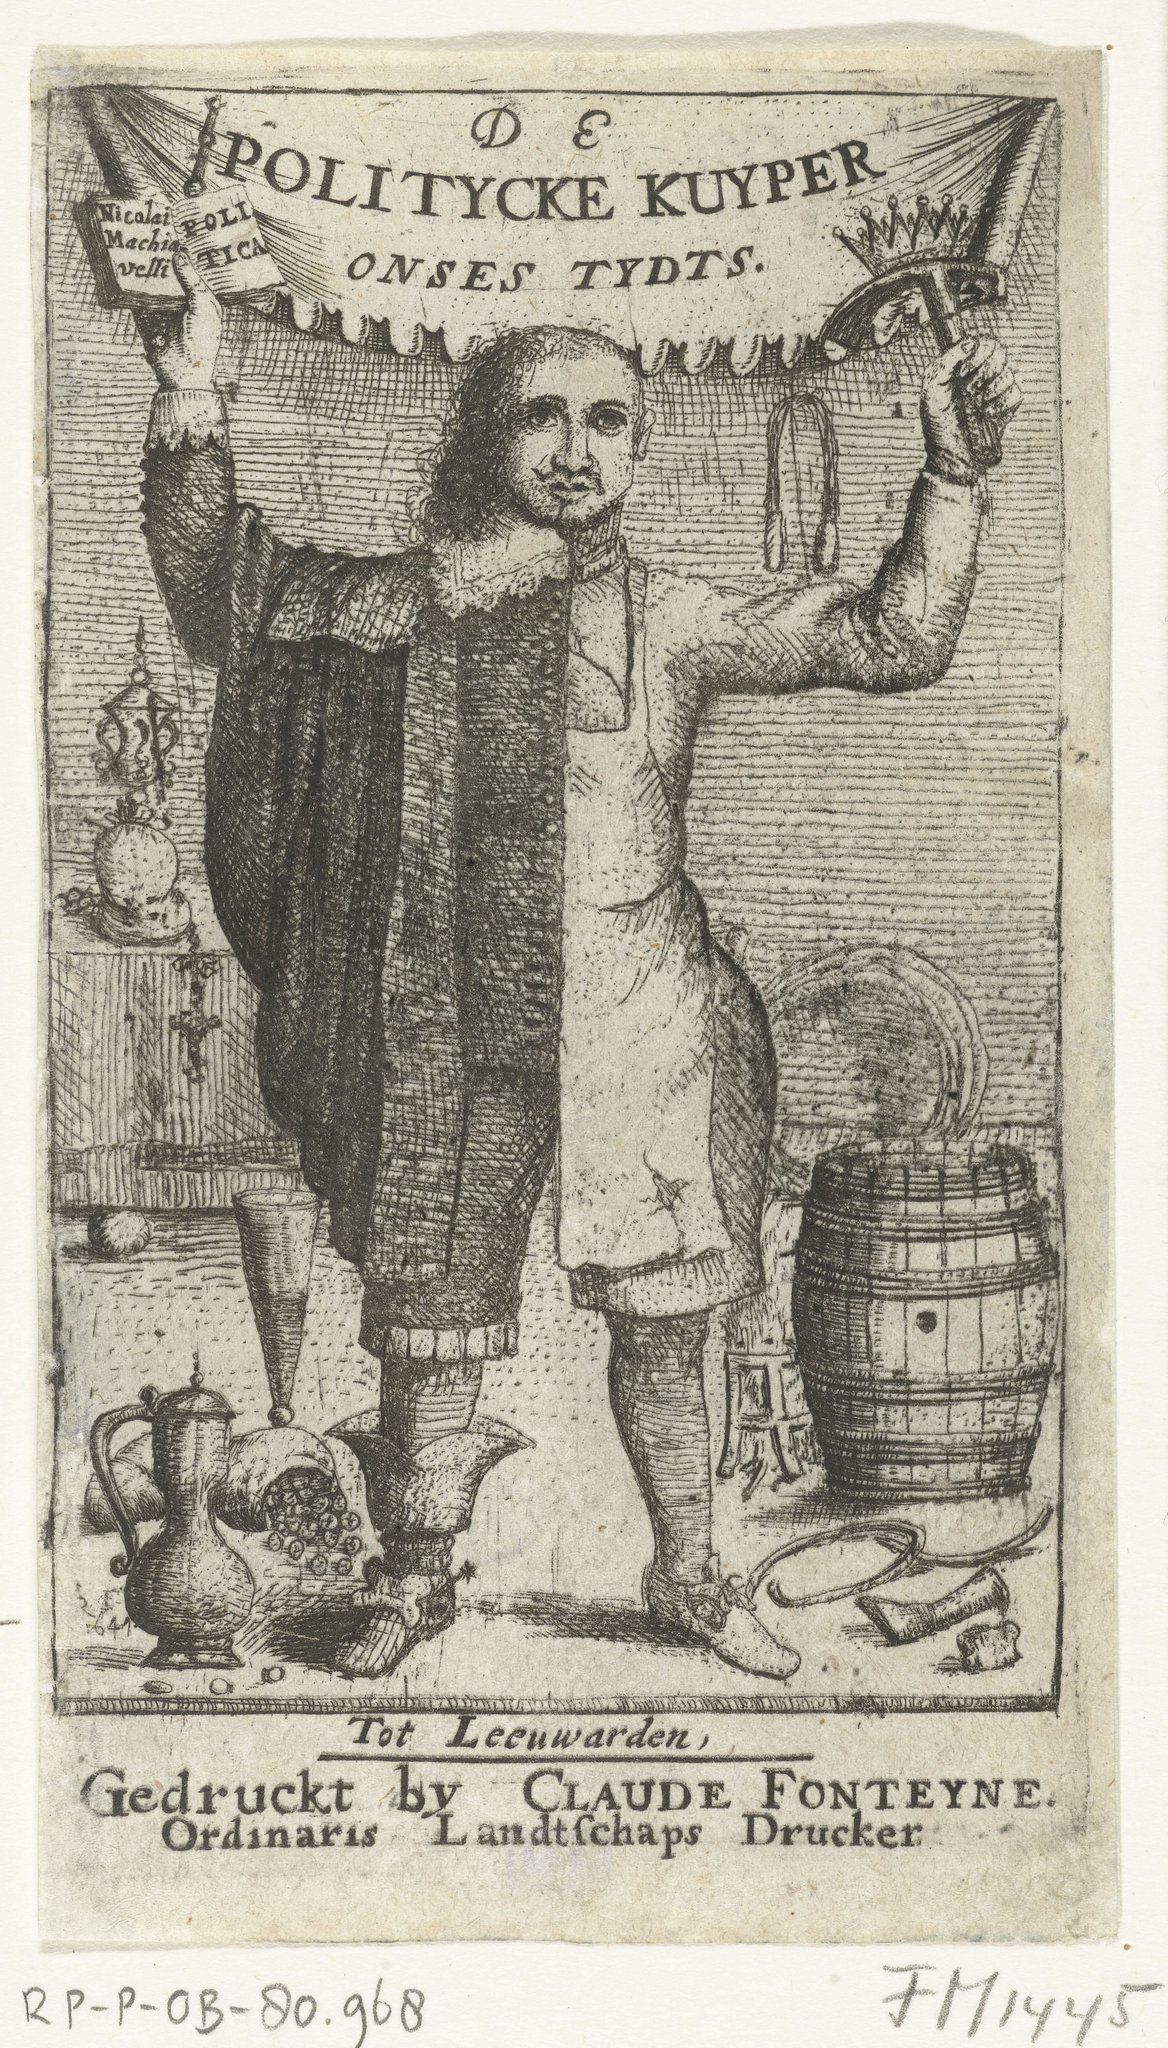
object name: titelprent, frontispice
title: Titelprent voor: De Politycke Kuyper onses tydts, 1647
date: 1647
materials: paper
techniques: engraving, etching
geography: northern netherlands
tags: wooden container: barrel, cask, bucket, other handicrafts ~ wood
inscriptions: date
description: Titelprent voor: De Politycke Kuyper onses tydts, 1647. Staande kuiper in tweeën gedeeld. De rechterhelft voorgesteld als staatsman met het boek Politica van Machiavelli in de hand, de linkerkant als kuiper met een hamer in de hand. Allegorie op de ambitie en eerzucht en de macht van de voorspraak in het verkrijgen van ambten. Titelprent voor het boek met een vers van J.J. Starter over hetzelfde onderwerp.